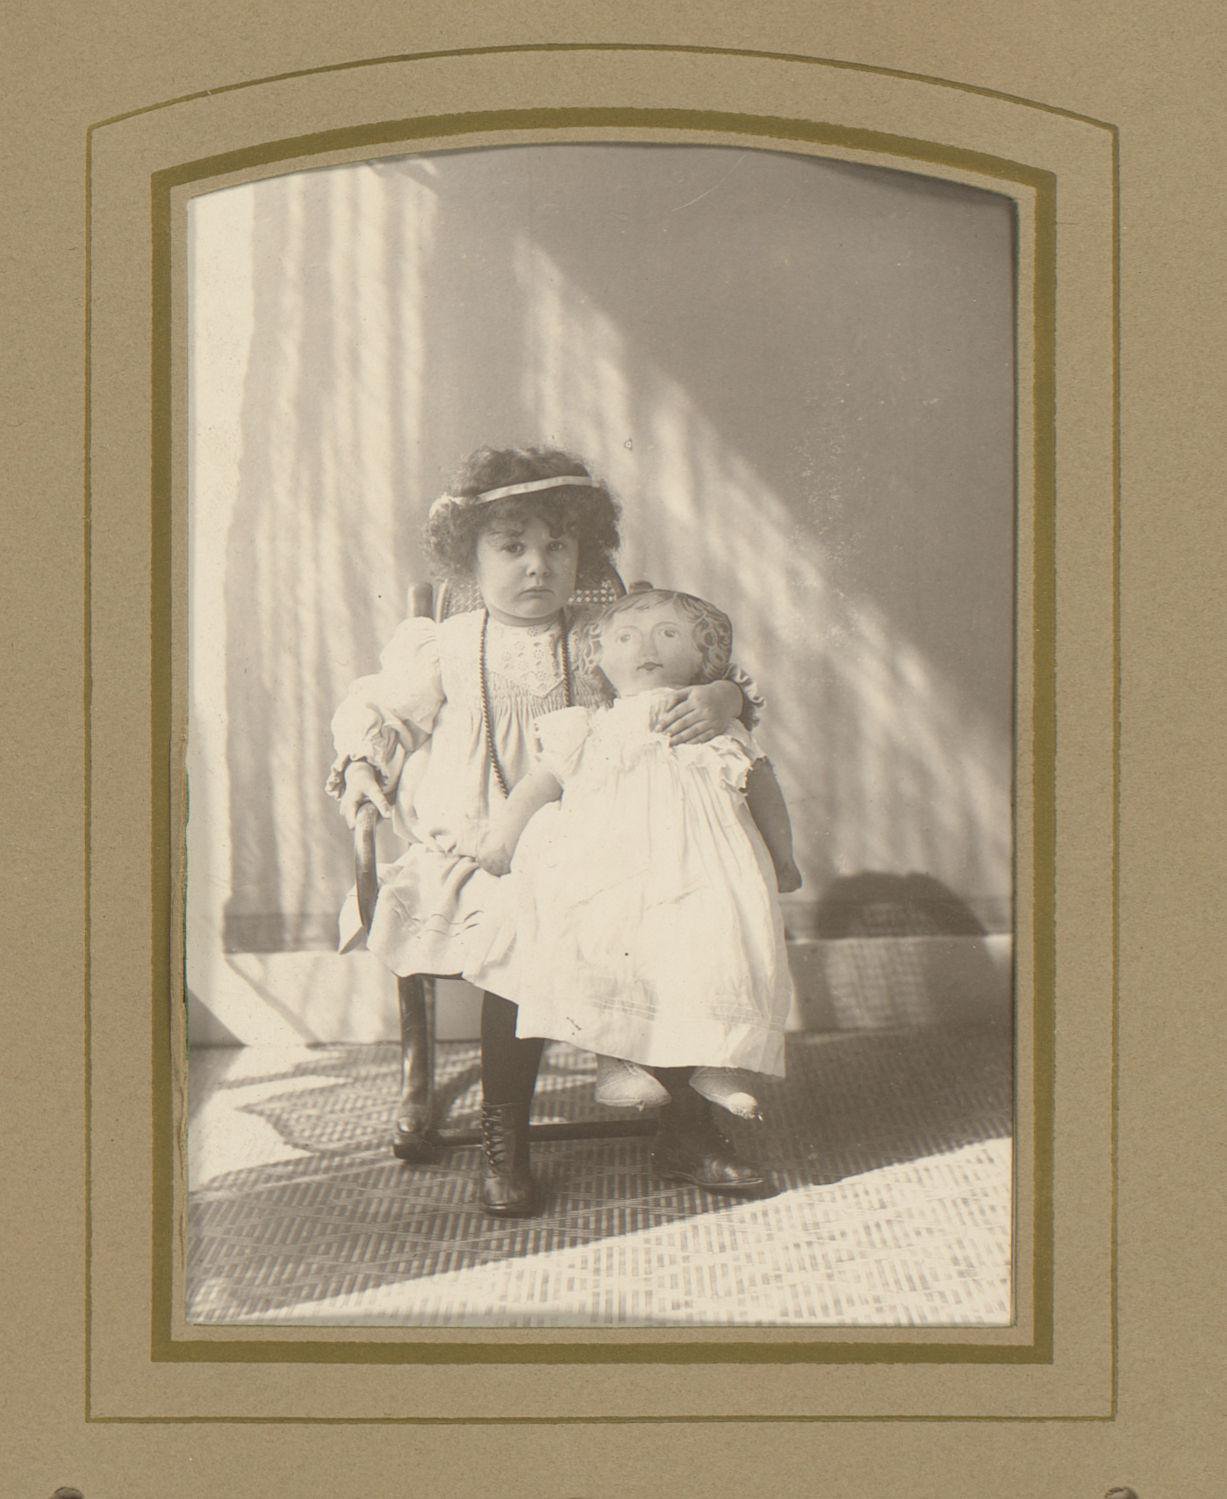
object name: album leaf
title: Portret van een kind op een stoel met een pop op schoot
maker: Anonymous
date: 1895-1920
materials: cardboard, photographic support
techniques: matte daylight collodion silver print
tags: historical persons - bb - woman, girl (child between toddler and youth), (playing with) dolls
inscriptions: number: ‘17’, number: ‘17’